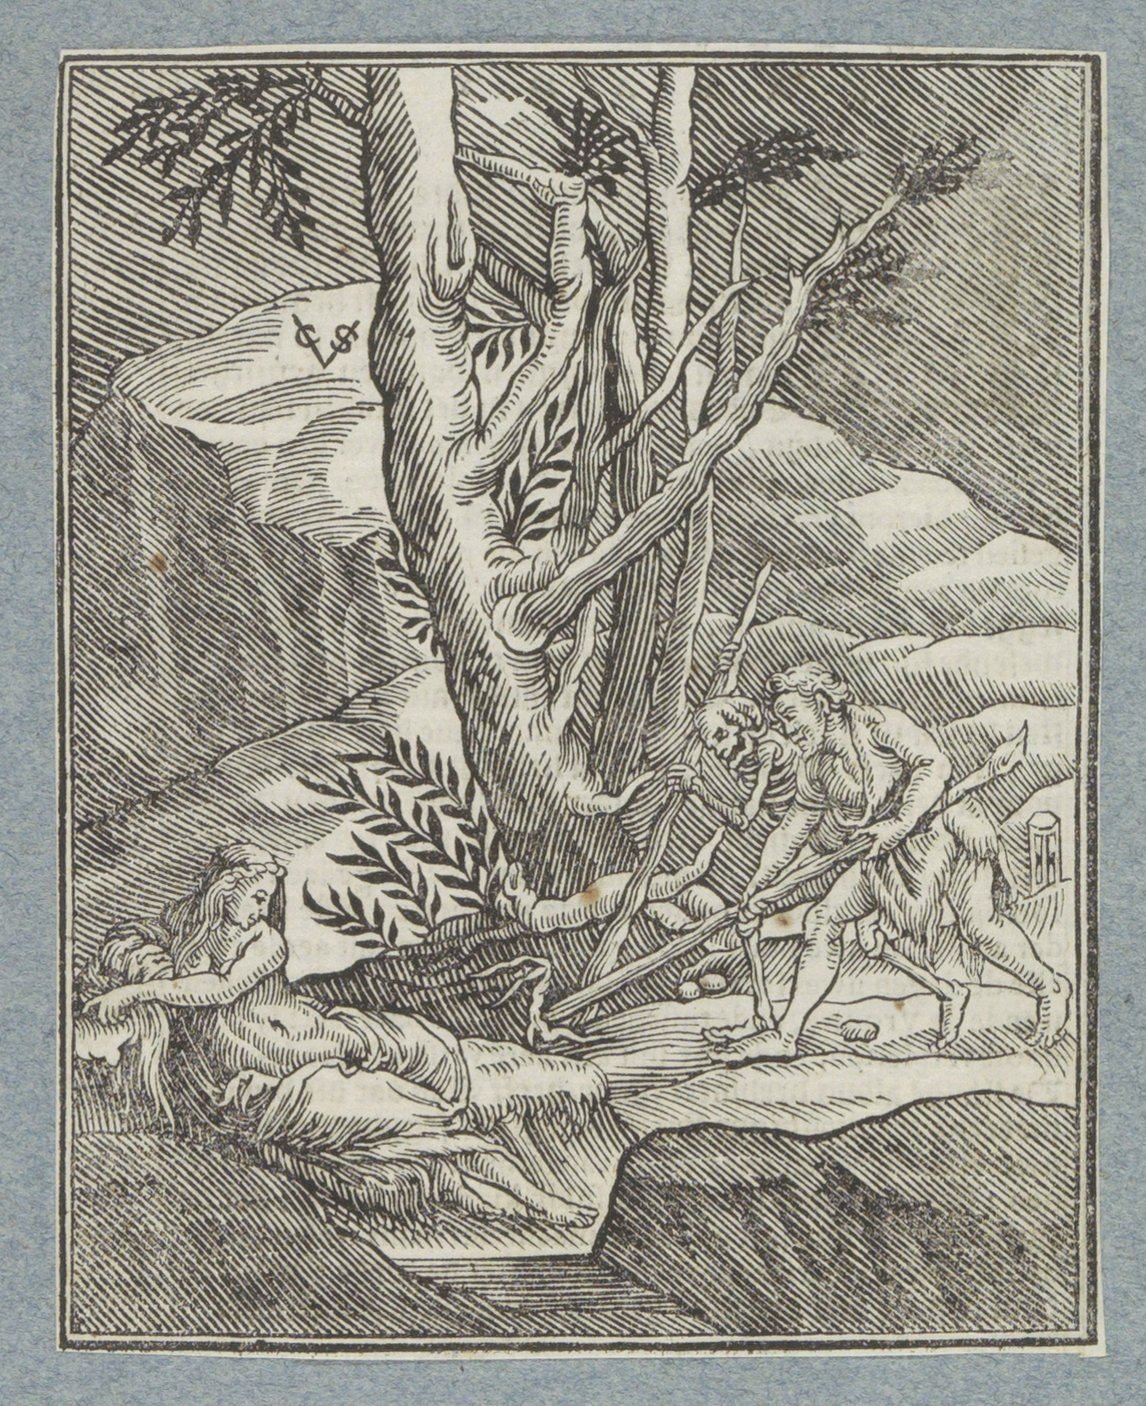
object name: book illustration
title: Adam, Eva en de Dood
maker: pieter jacobsz. paets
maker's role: publisher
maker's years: 1587-1667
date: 1645-1646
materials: paper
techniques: letterpress printing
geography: amsterdam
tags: adam engaged in agricultural activities, eve suckling the children, dance of death; death together with one or more human beings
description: De prent werd gemaakt voor de uitgaven van P.J. Paets uit Amsterdam. Ze komt in ieder geval voor in: Bibels Tresoor ofte der zielen lusthof. Amsterdam, P.J. Paets, 1646. Mogelijk ook in: Historien ende Prophetien. [Amsterdam], P.J. Paets, 1645.